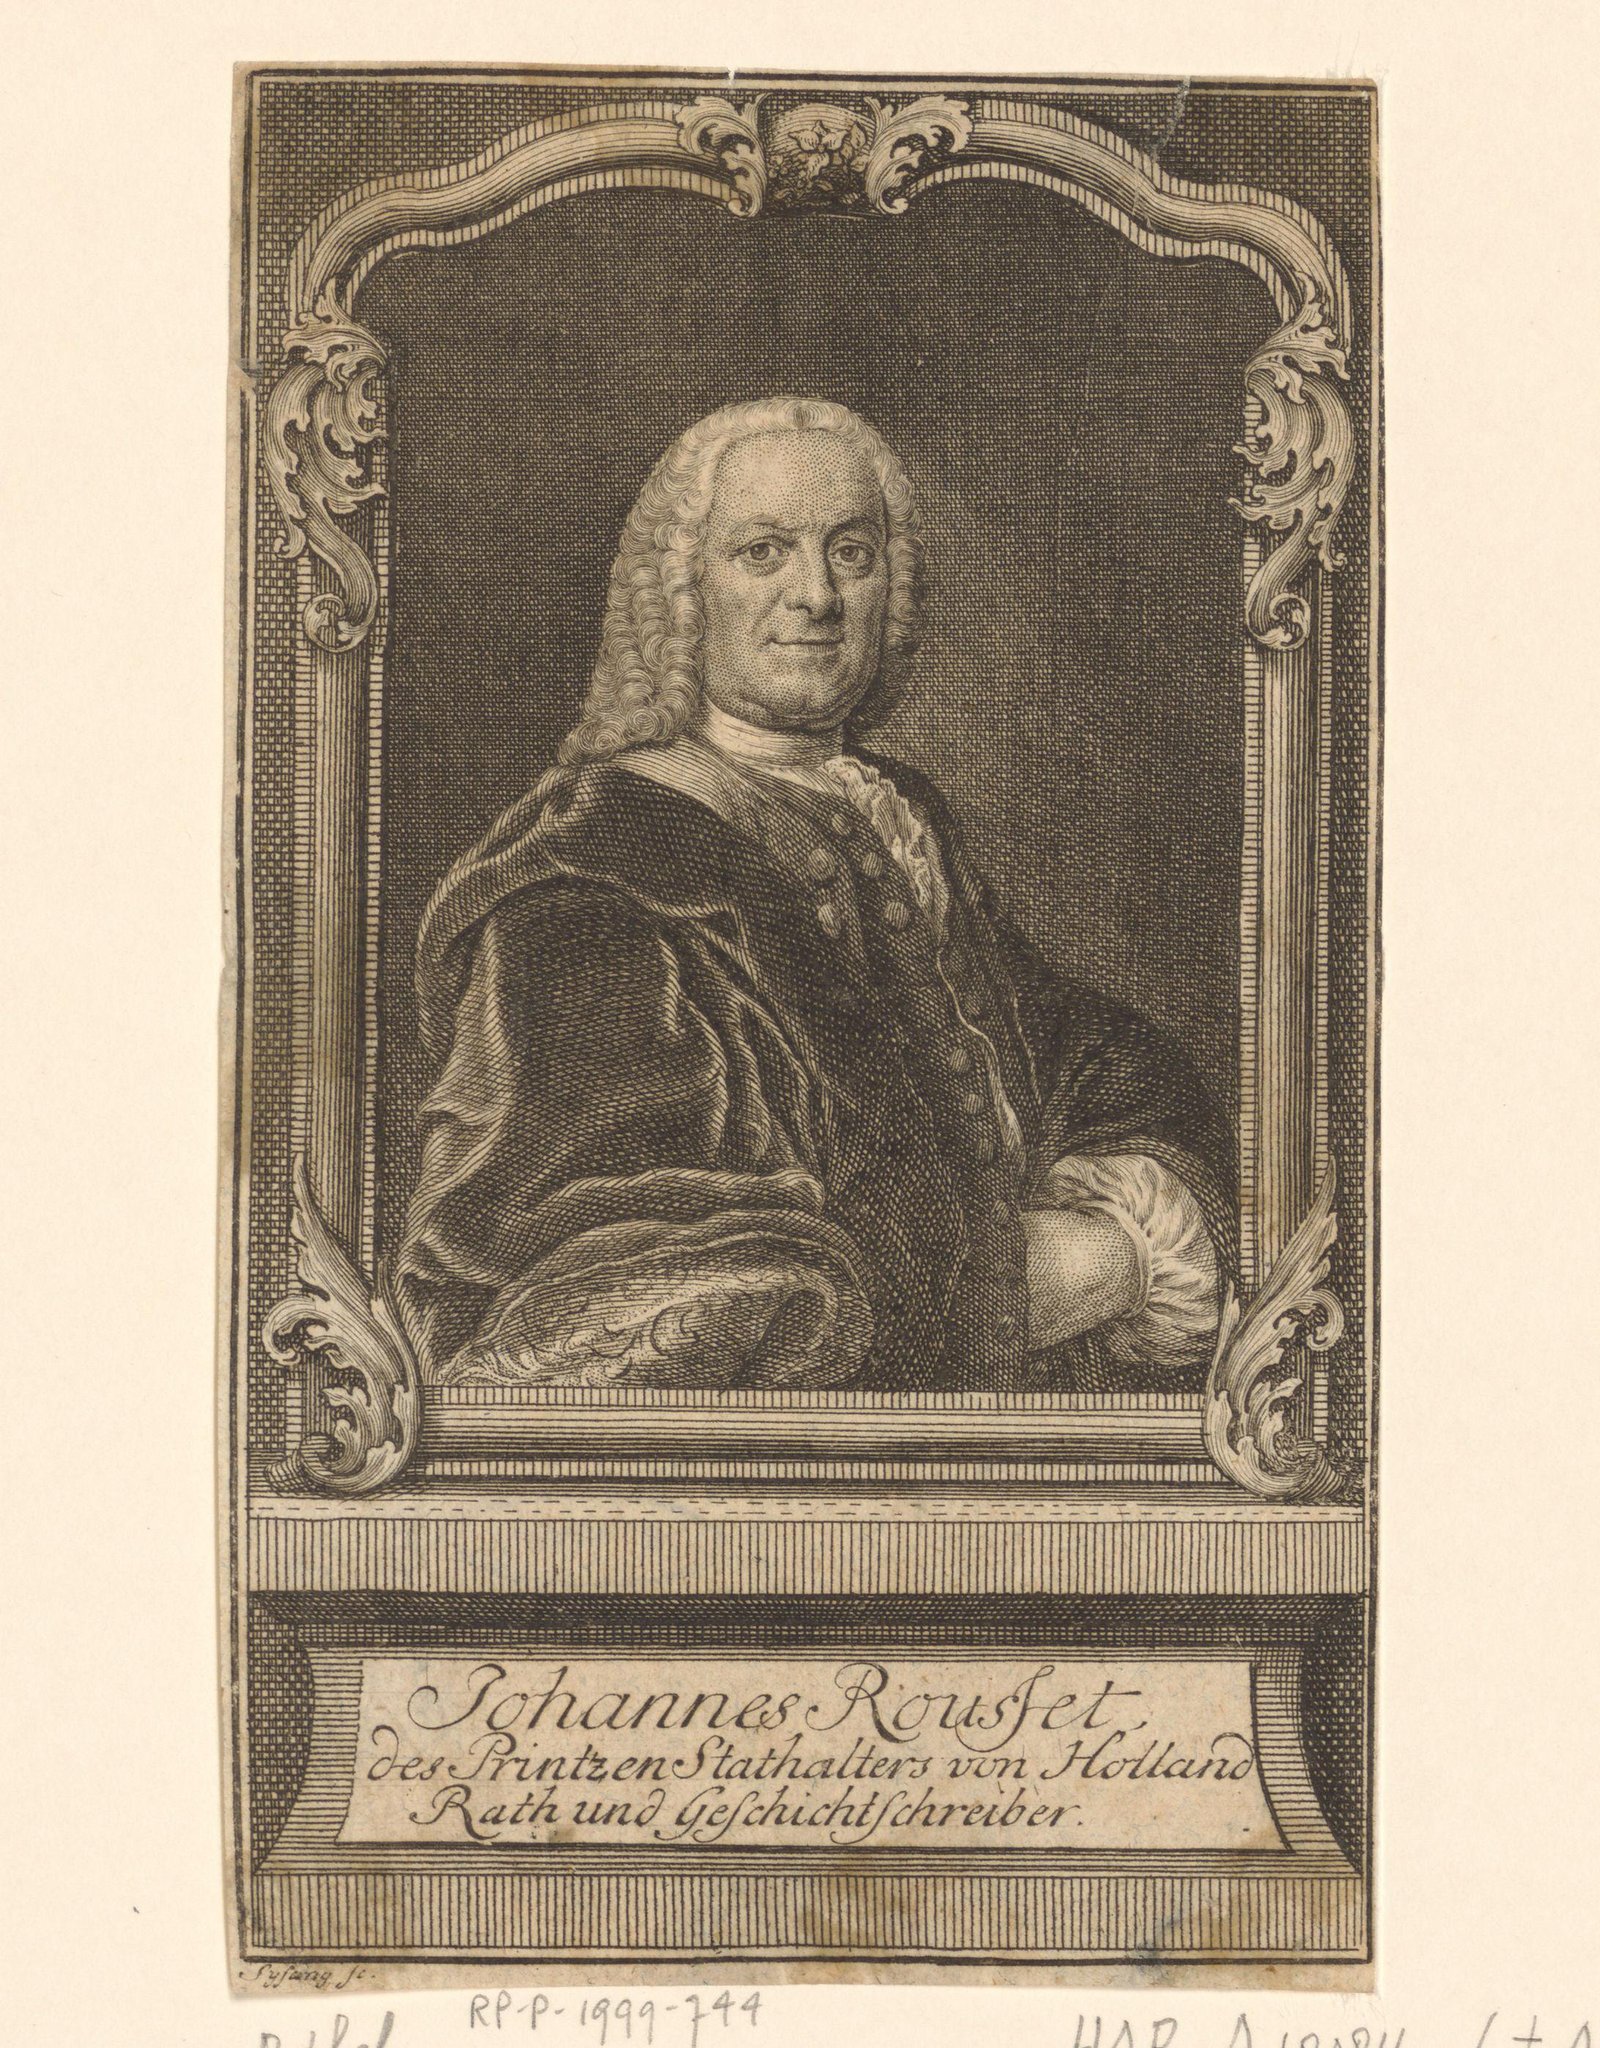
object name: print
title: Portret van Jean Rousset de Missy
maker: johann christoph sysang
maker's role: print maker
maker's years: 1703-1757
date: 1749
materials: paper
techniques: engraving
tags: amsterdam, historical persons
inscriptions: collector's mark: Lugt 2228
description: Prent waarschijnlijk uit: Zuverlässige Nachrichten von dem gegenwärtigen Zustande, Veränderung und Wachsthum der Wissenschaften. Leipzig: erven Johann Gottlieb Gleditsch, 1749.